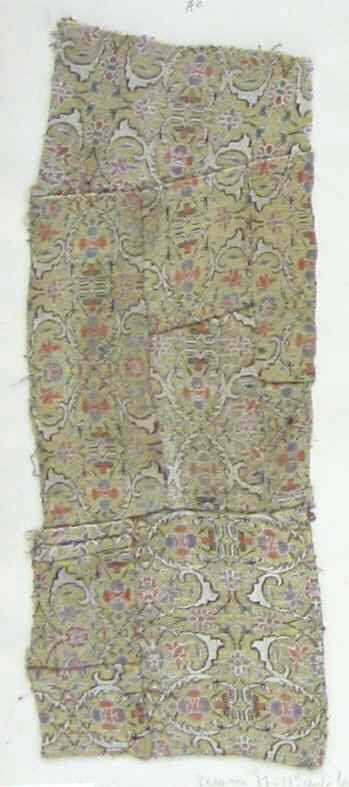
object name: textile fragment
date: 1601-1800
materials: metal thread, silk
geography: iran